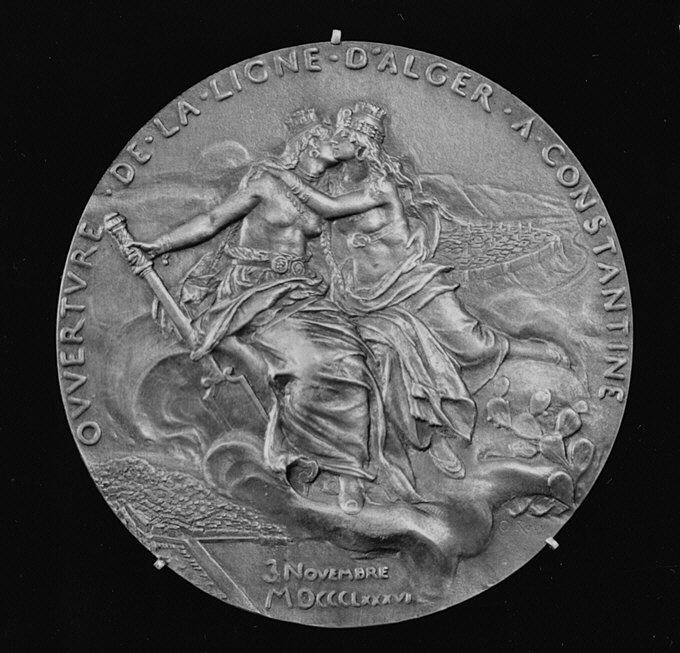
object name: medal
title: Opening of the Railway Line Between Algiers and Constantine, November 3, 1886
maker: louis-oscar roty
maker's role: artist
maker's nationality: french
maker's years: 1846-1911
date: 1886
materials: bronze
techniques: silvered, struck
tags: female nudes,medals